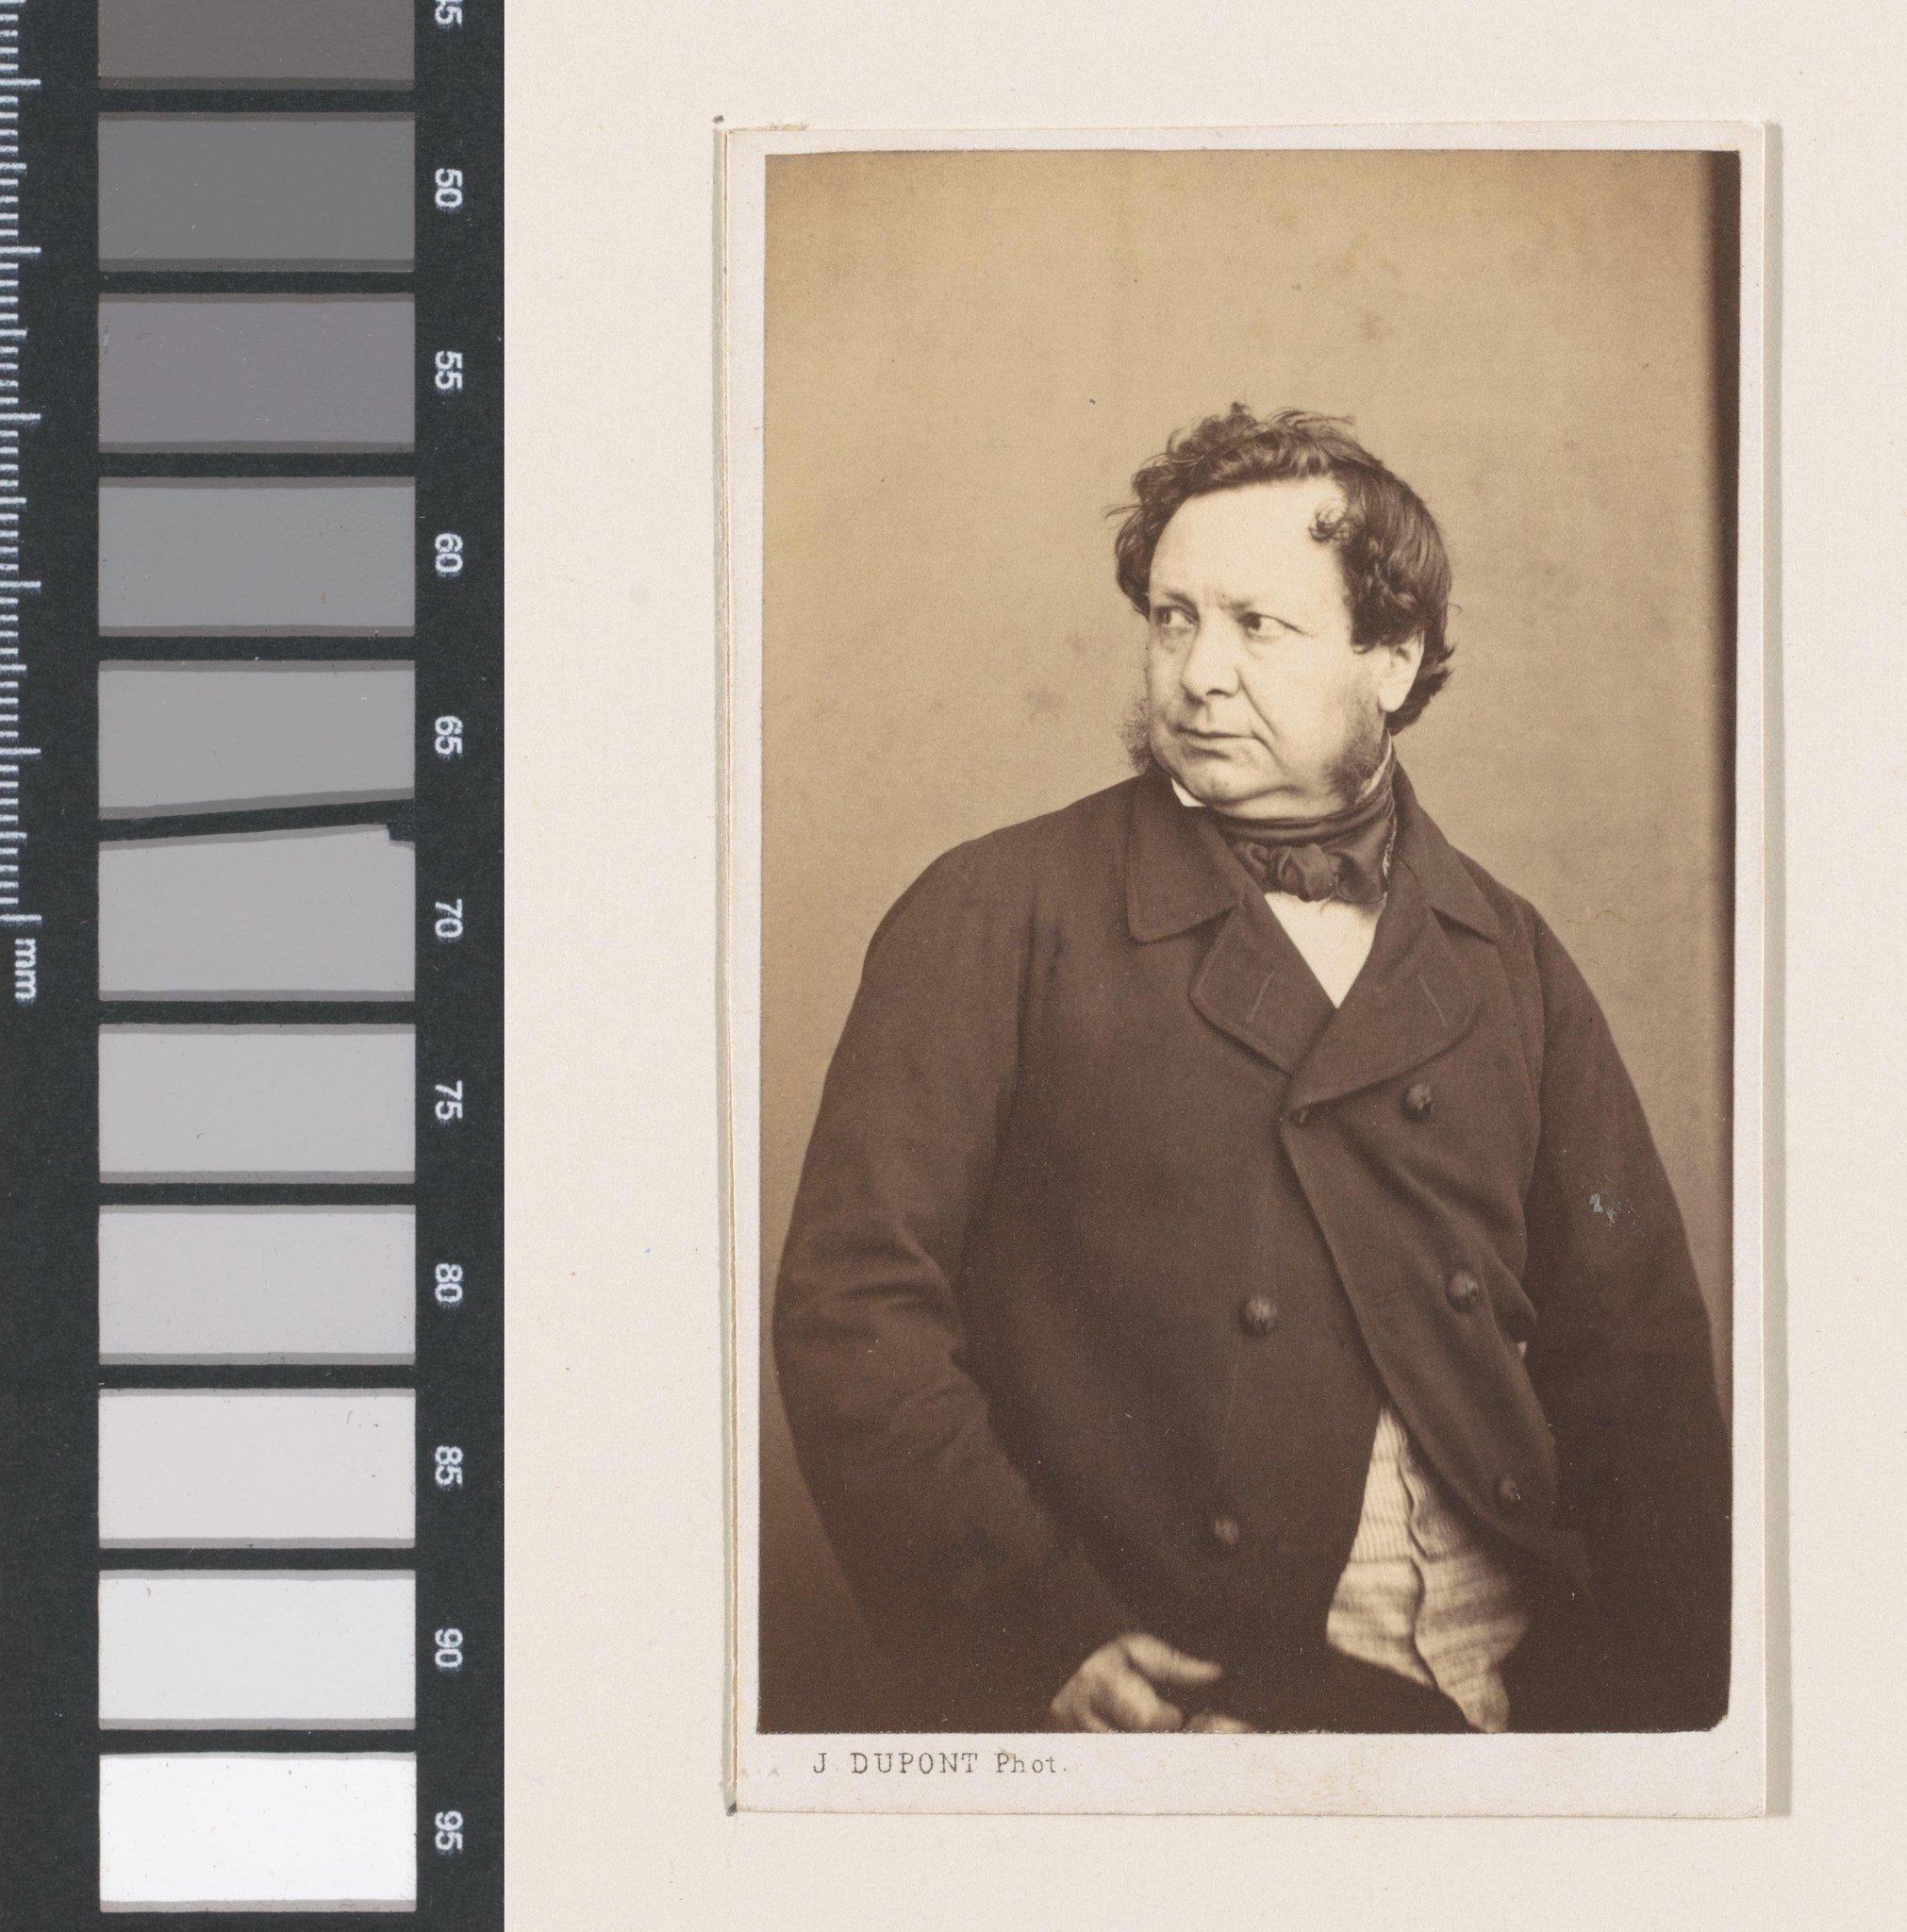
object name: photograph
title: L'École d'Anvers. Portraits biographies cartes de visite. Collection Dupont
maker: joseph dupont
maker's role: fotograaf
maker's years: 1818-1901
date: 1861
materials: cardboard, paper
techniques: albumen print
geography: antwerp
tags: historical persons, professor (+ portrait of teacher, professor)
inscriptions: inscription: ‘ETABLISSEMENT PHOTOGRAPHIQUE/ de/ J. DUPONT/ Place de Meir 32/ ANVERS/ Maison fondée en 1853’